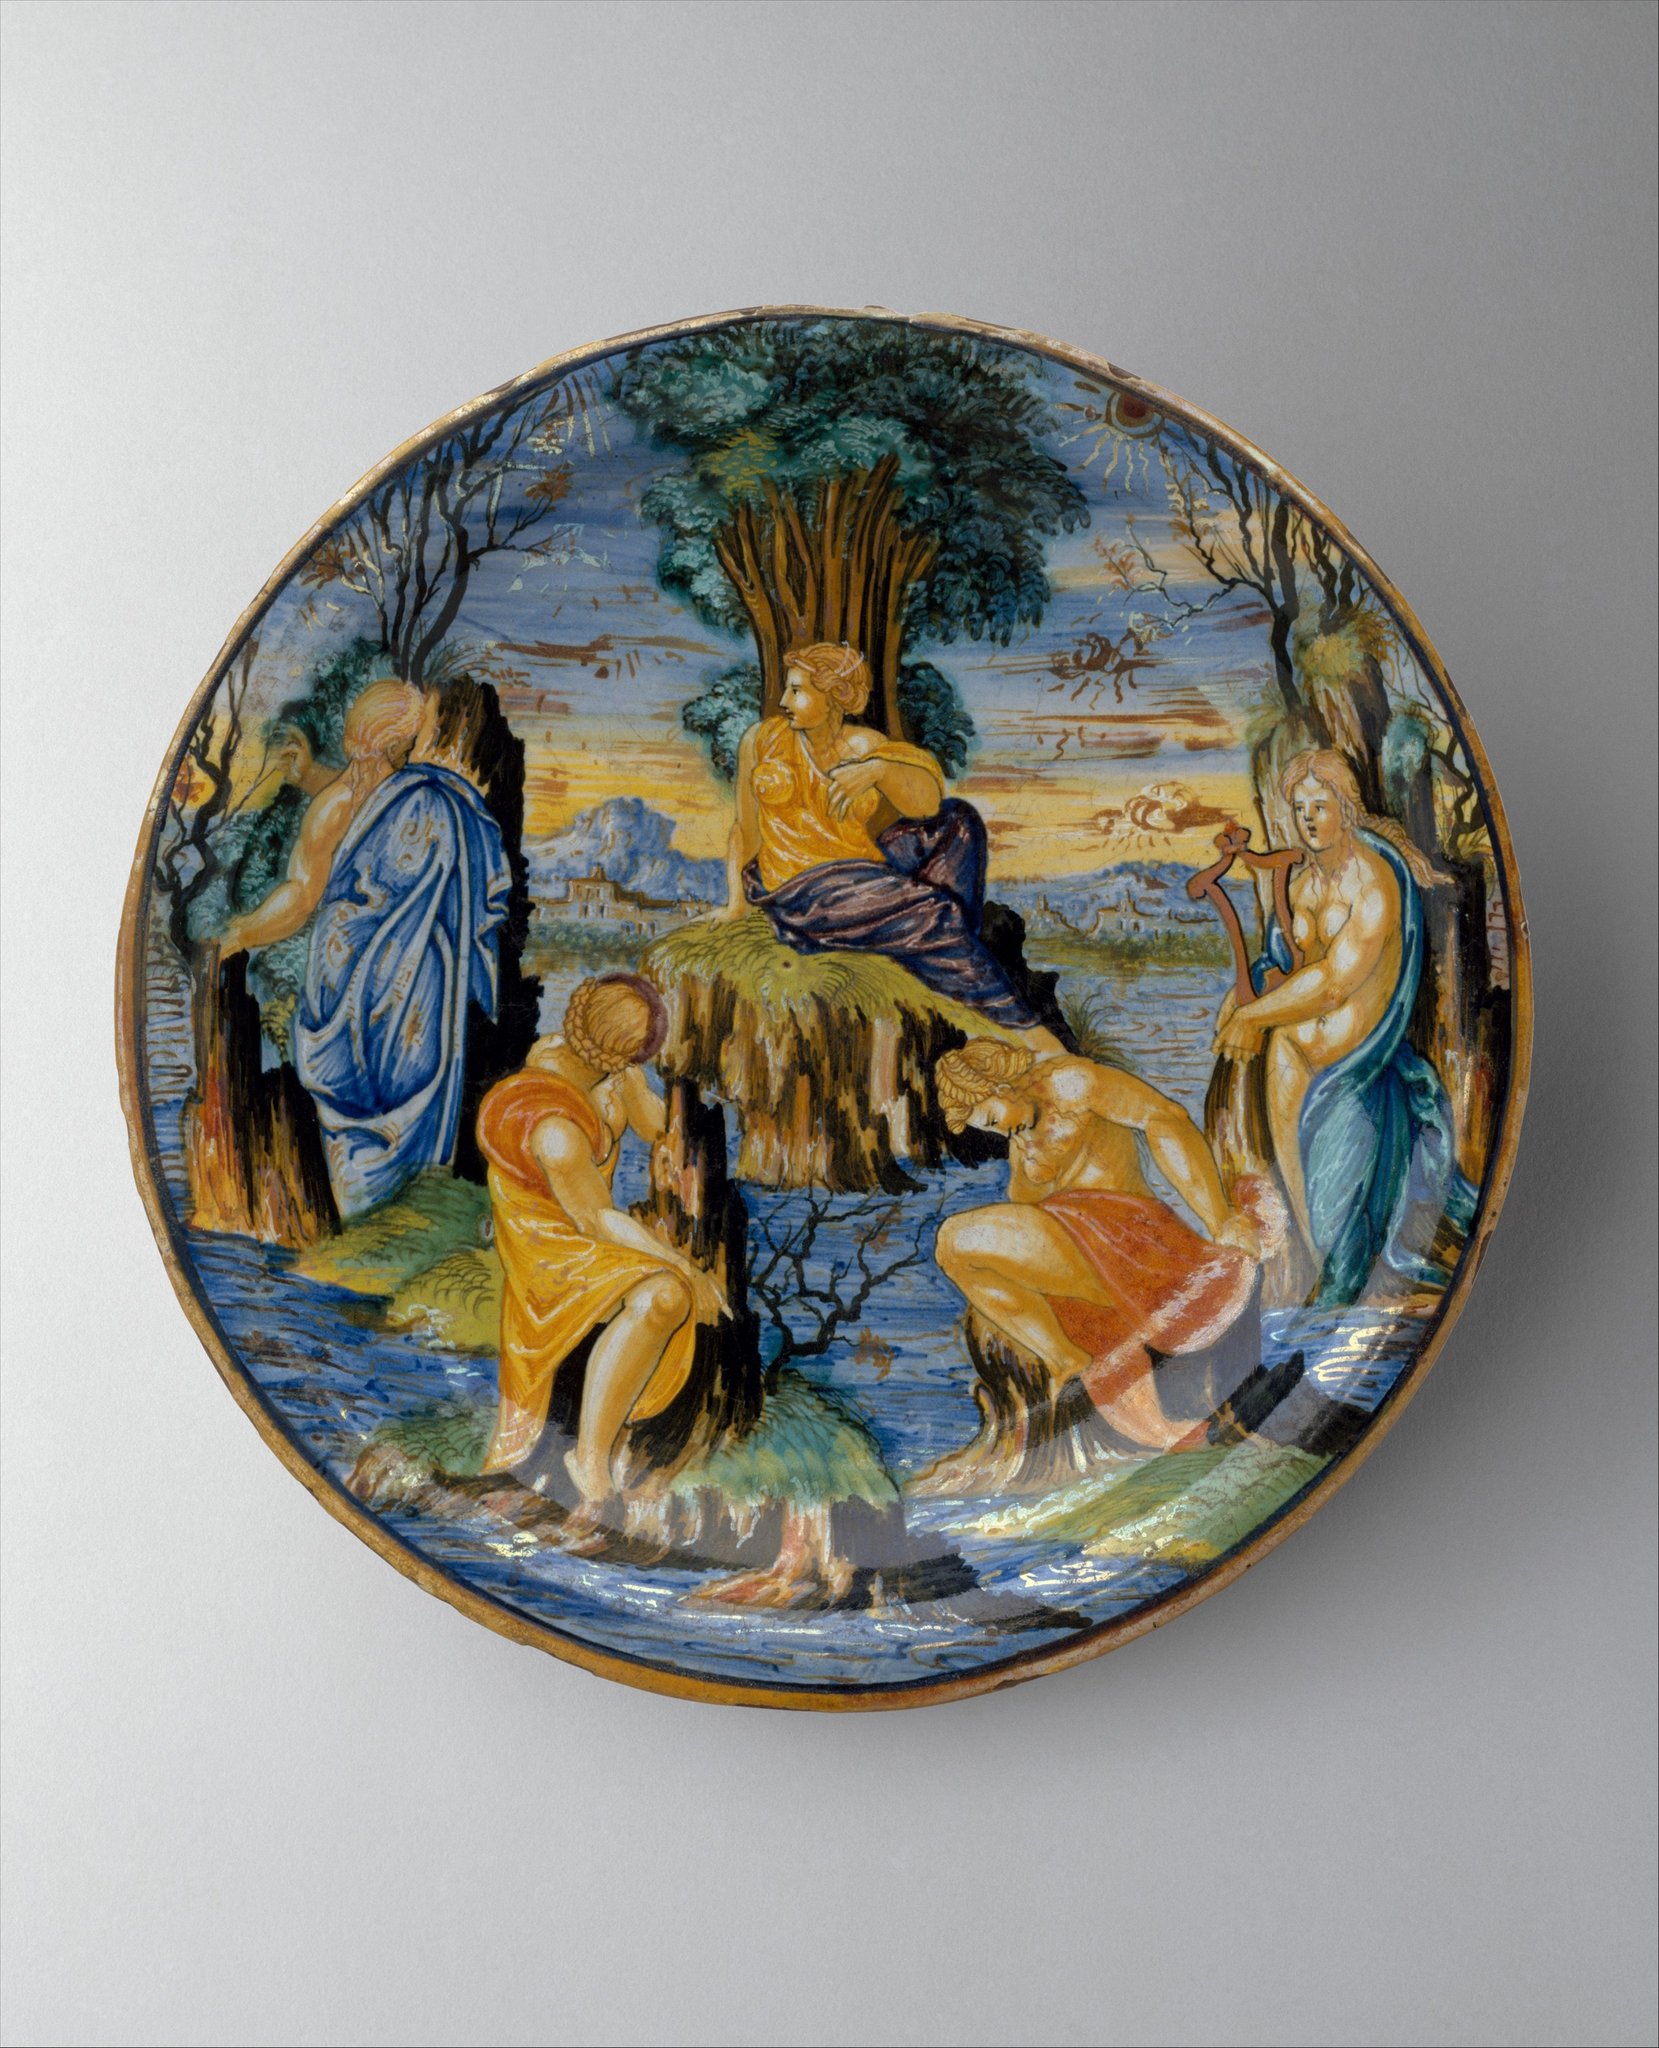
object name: dish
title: Dish (piatto)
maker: francesco xanto avelli da rovigo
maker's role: artist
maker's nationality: italian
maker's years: 1482-1542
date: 1532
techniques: maiolica, glazing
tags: women,female nudes